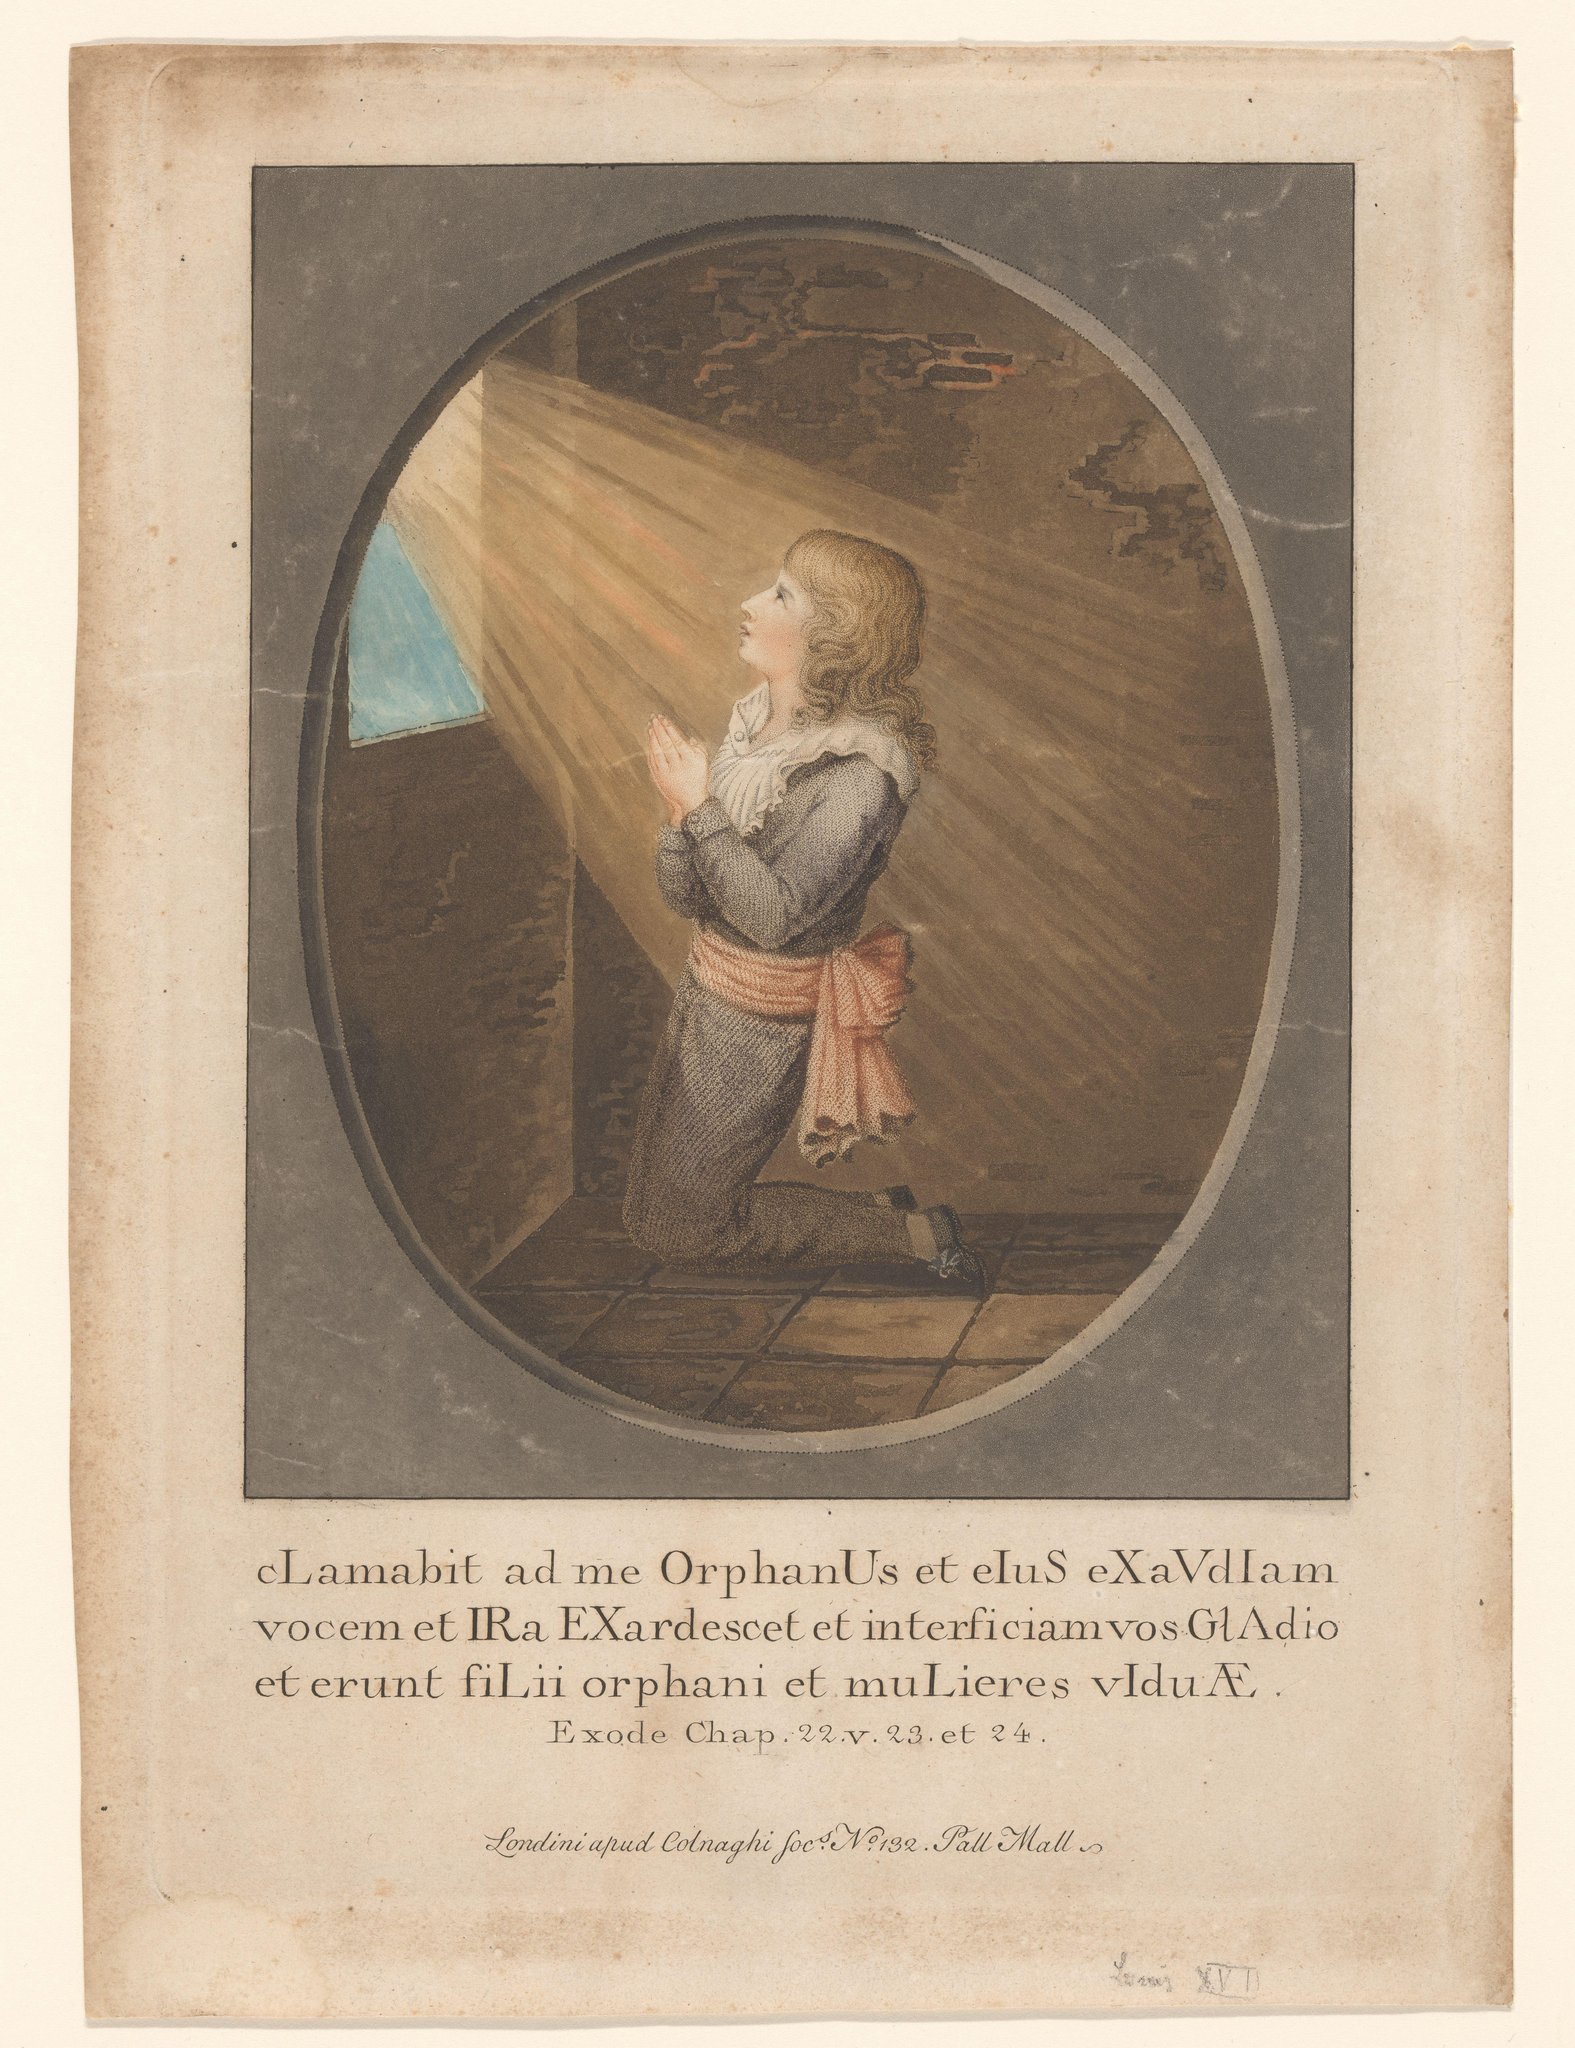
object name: print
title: Lodewijk XVII biddend in gevangenschap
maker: Anonymous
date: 1795-1899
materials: paper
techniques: aquatint, engraving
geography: london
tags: historical persons, one person praying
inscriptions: collector's mark: Lugt 2228